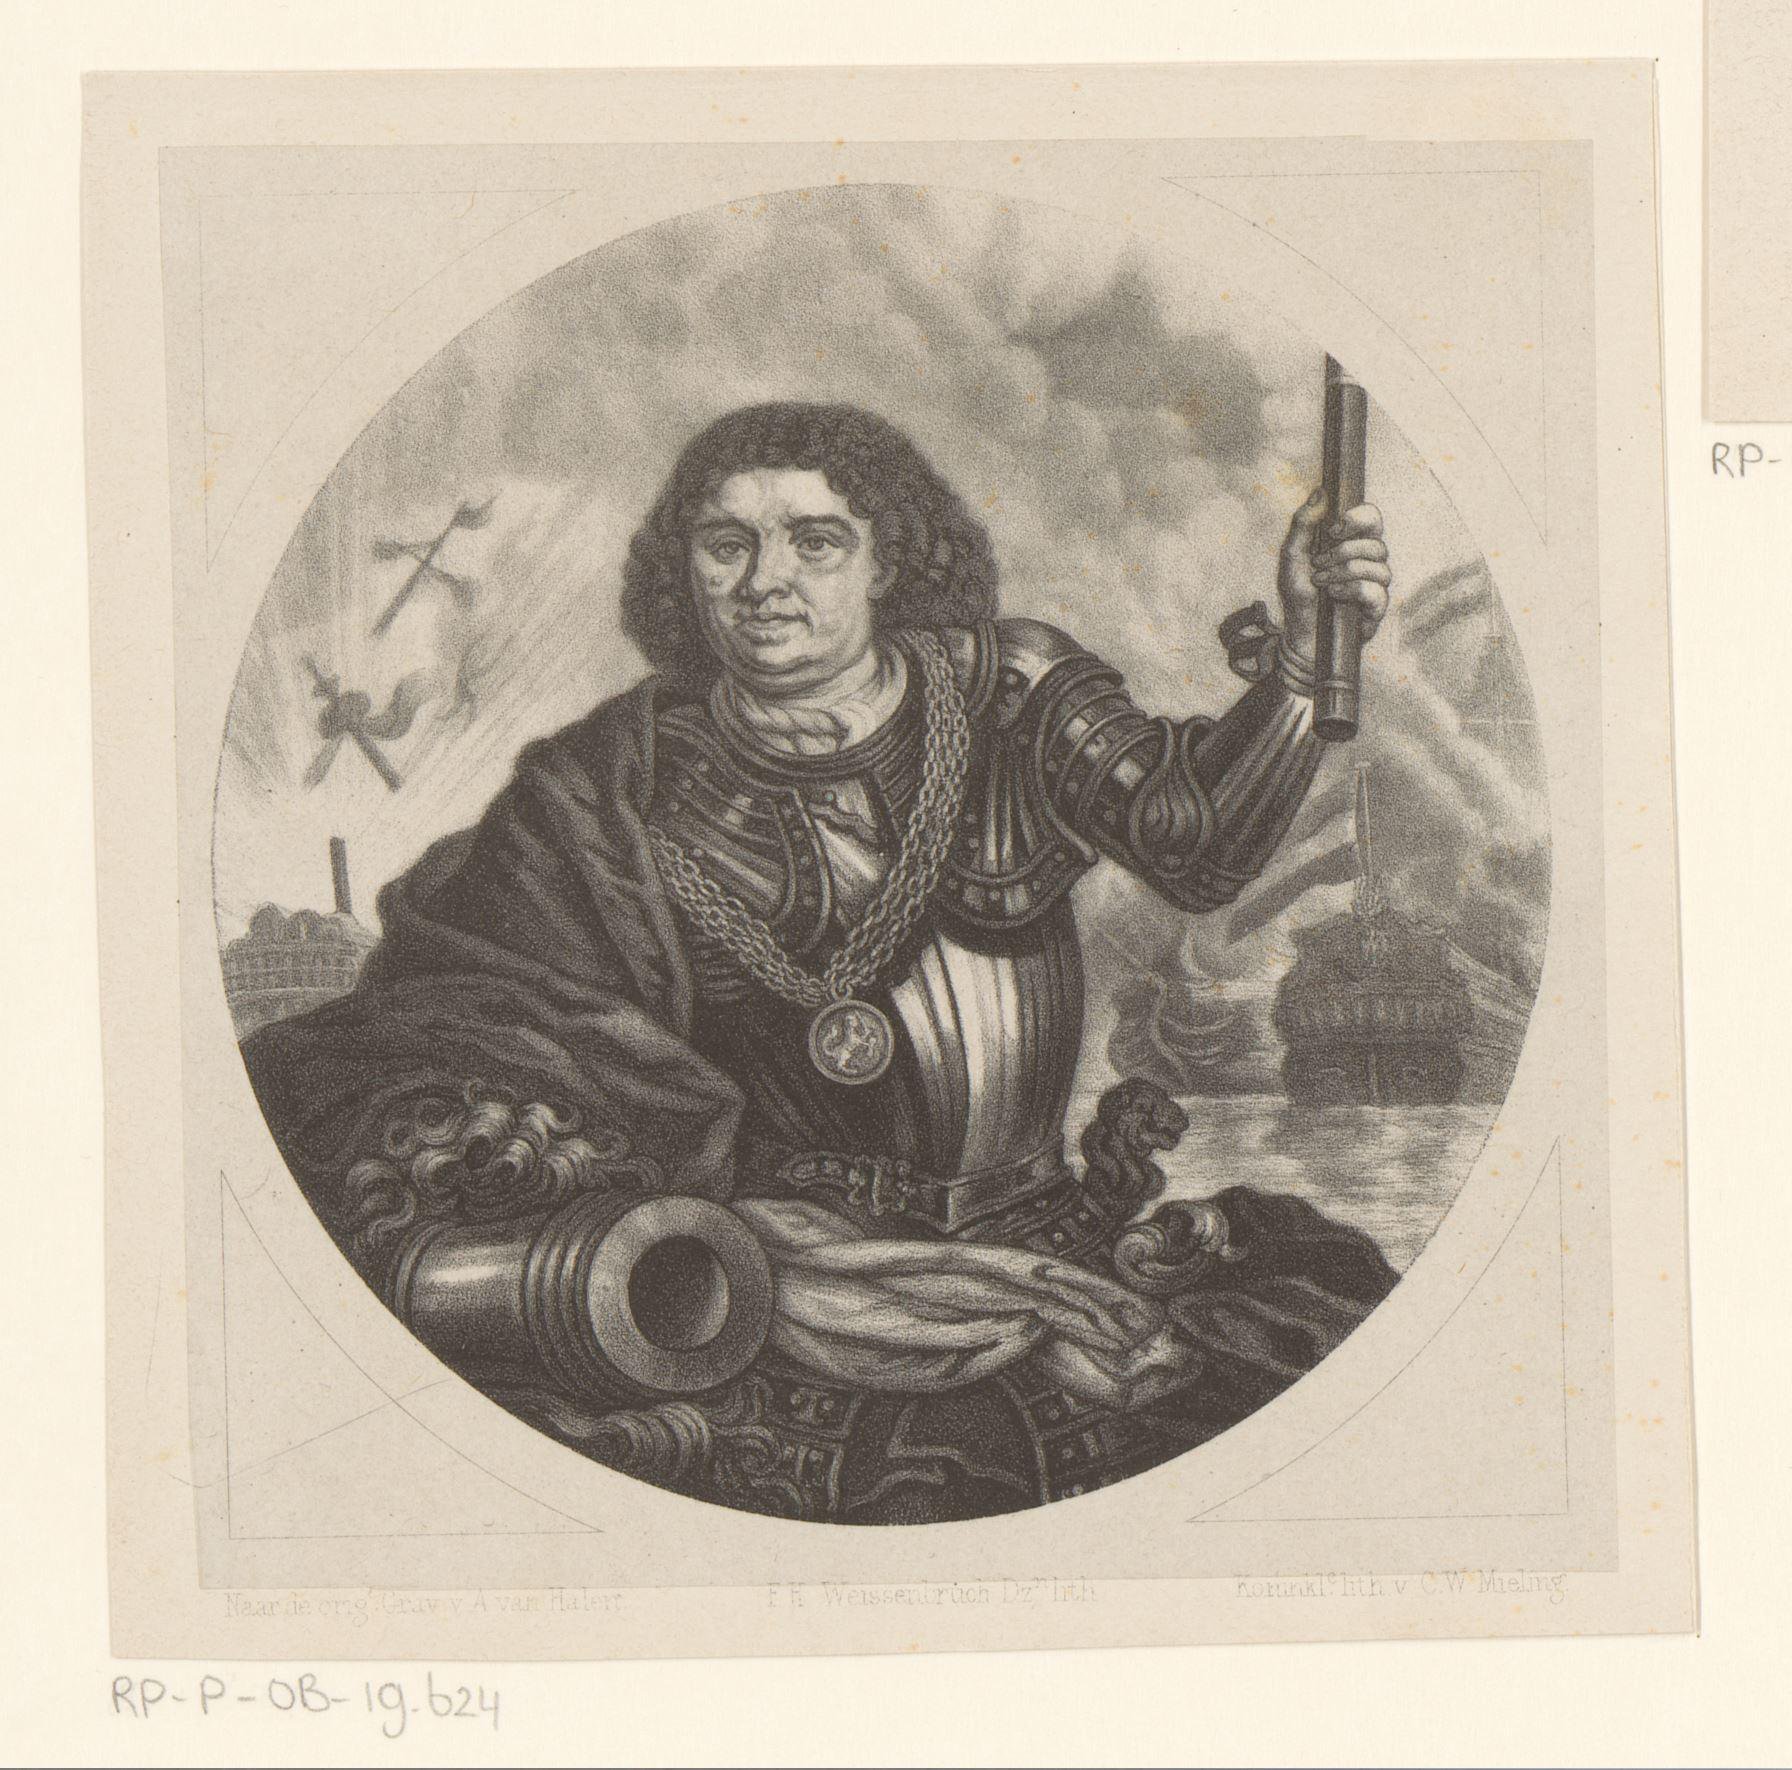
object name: print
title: Portret van Gilles Schey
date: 1858-1862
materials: paper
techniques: lithograph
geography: the hague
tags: historical persons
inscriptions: collector's mark: Lugt 2228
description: Prent uit: Jonge, J.C. de. Geschiedenis van het Nederlandsche zeewezen. Haarlem: Jonge, J.K.J. de, 1858-62.